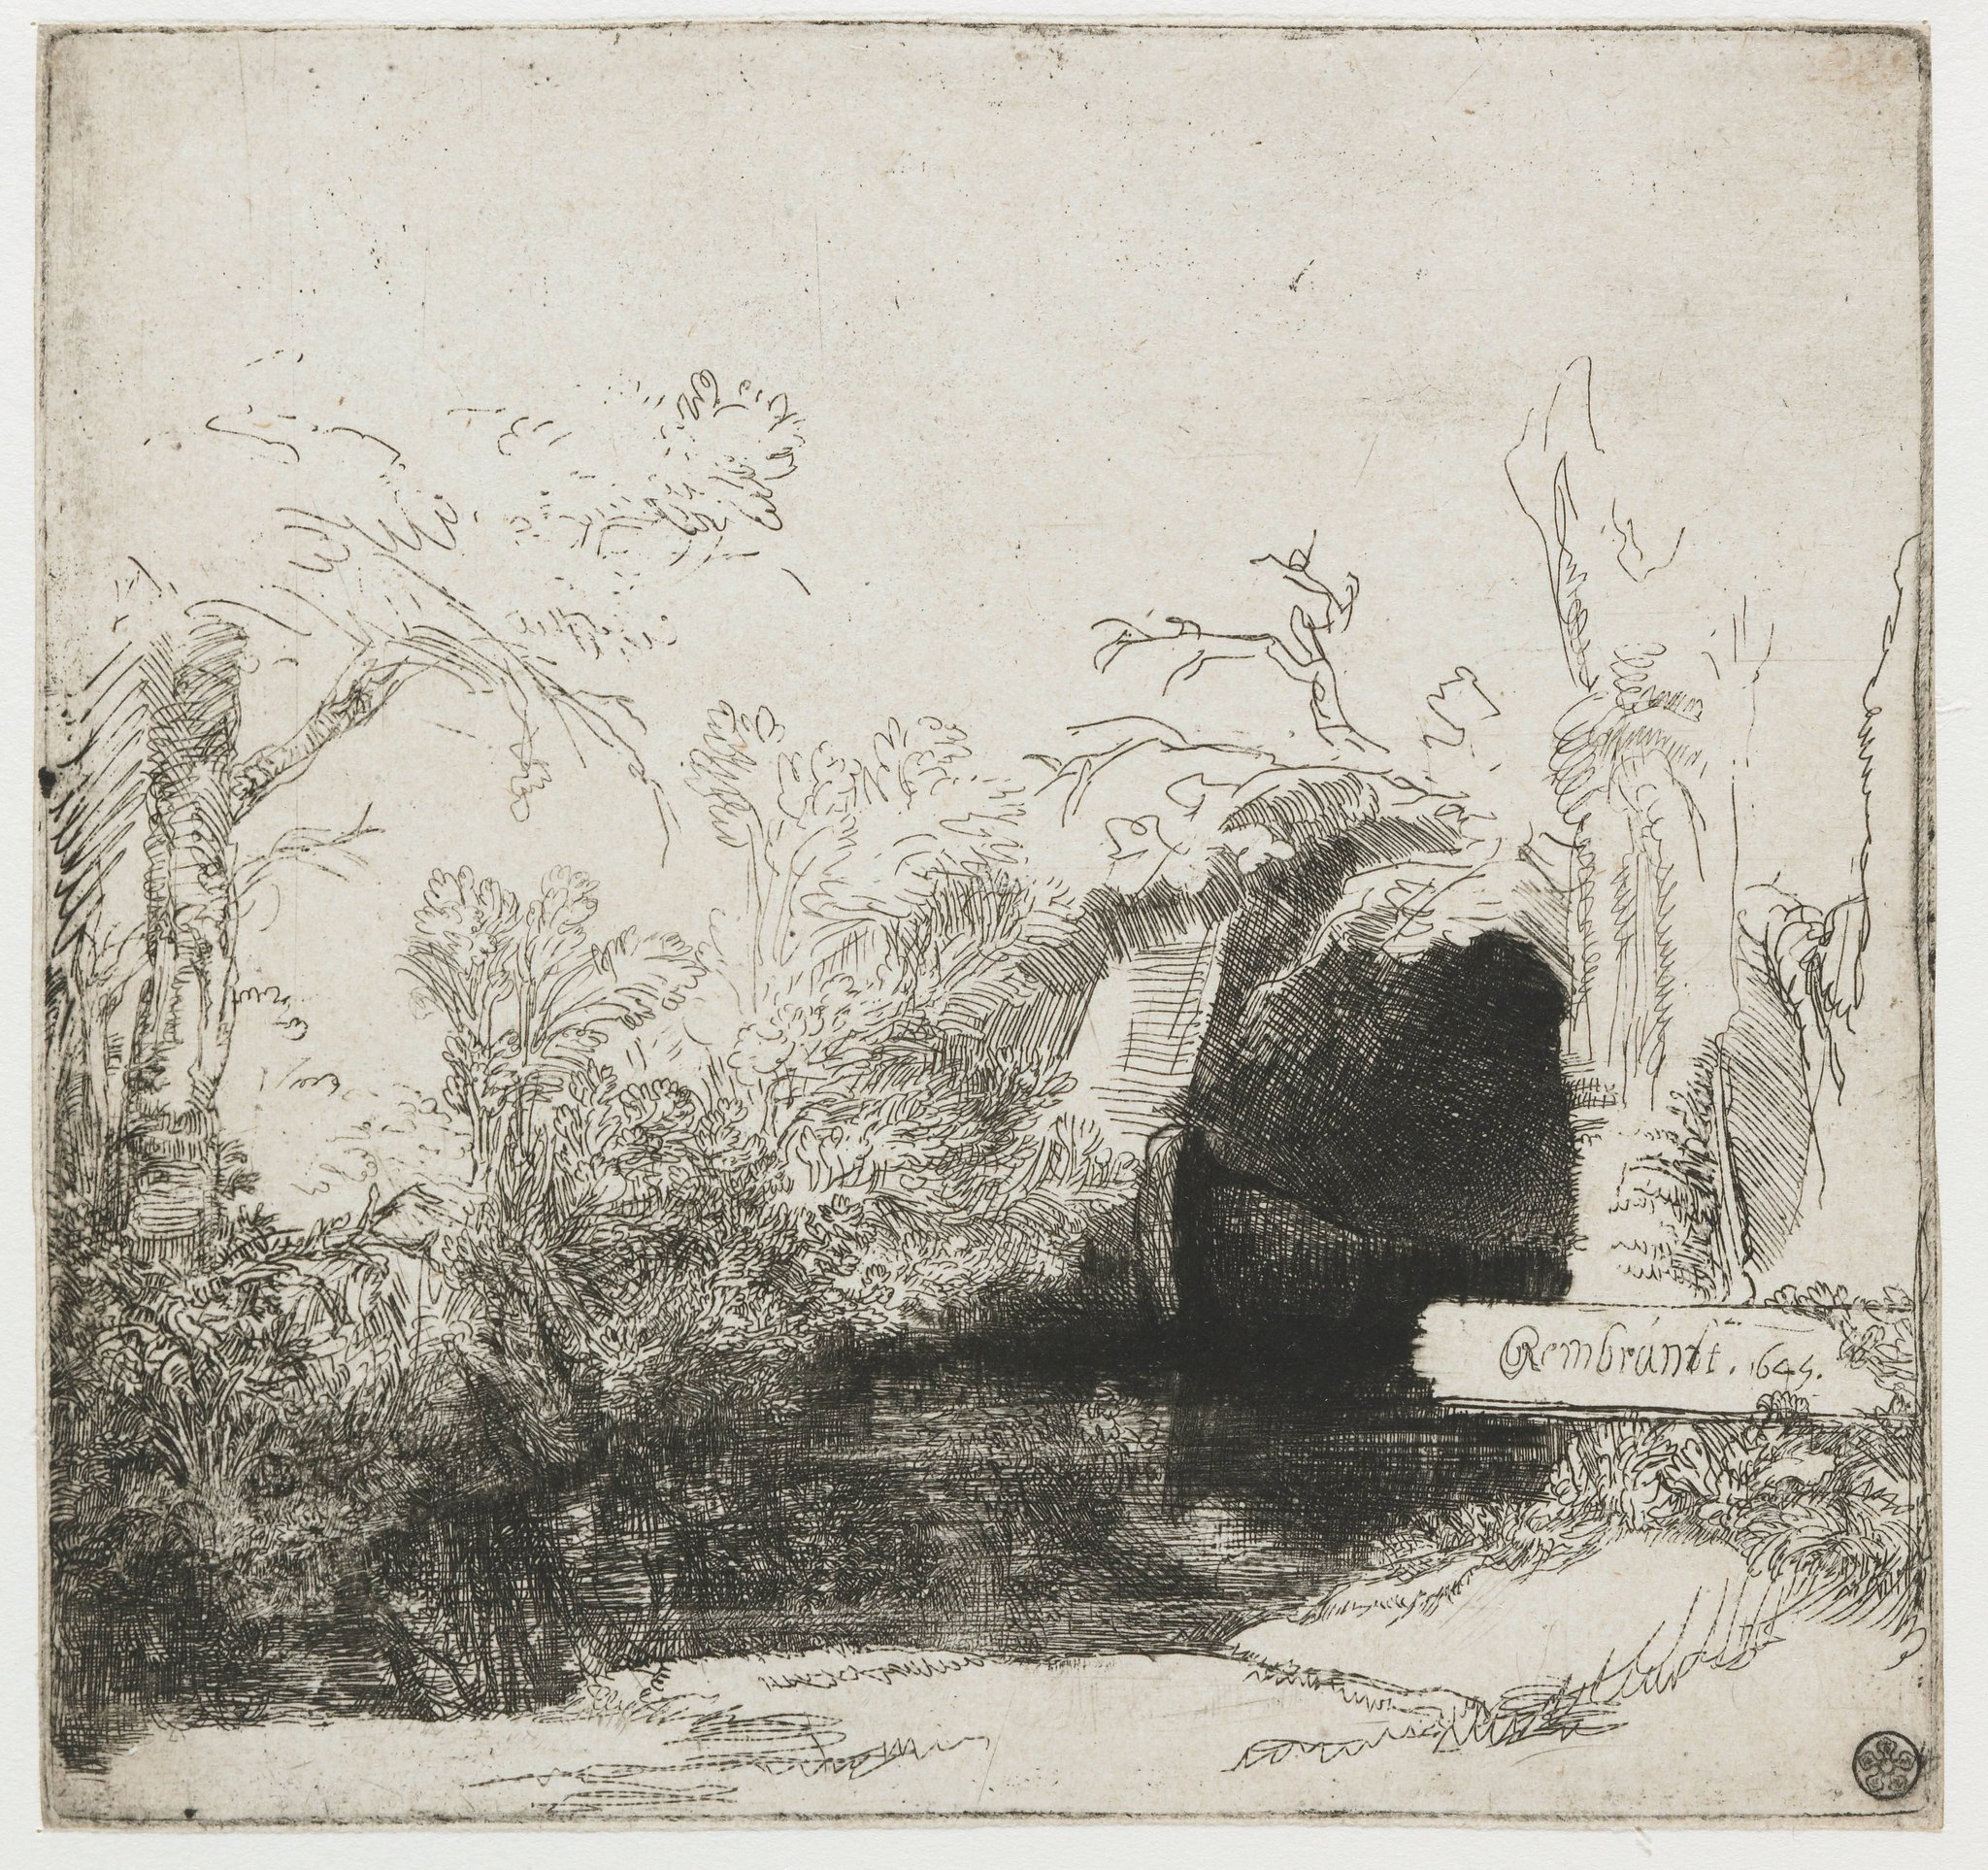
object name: print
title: A brook with a grotto and a boat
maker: rembrandt van rijn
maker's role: draughtsman, painter, print maker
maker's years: 1606-1669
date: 1645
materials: paper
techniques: drypoint, etching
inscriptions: signature and date: ‘Rembrandt . 1645’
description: The boat in this shadowy grotto is hardly visible. The dark passage contrasts with the surroundings, which are laid down on the plate with a few sketchy lines. This etching seems unfinished; however, it is signed and dated and was frequently printed. It is noteworthy that Rembrandt chose this landscape to showcase his name so prominently.